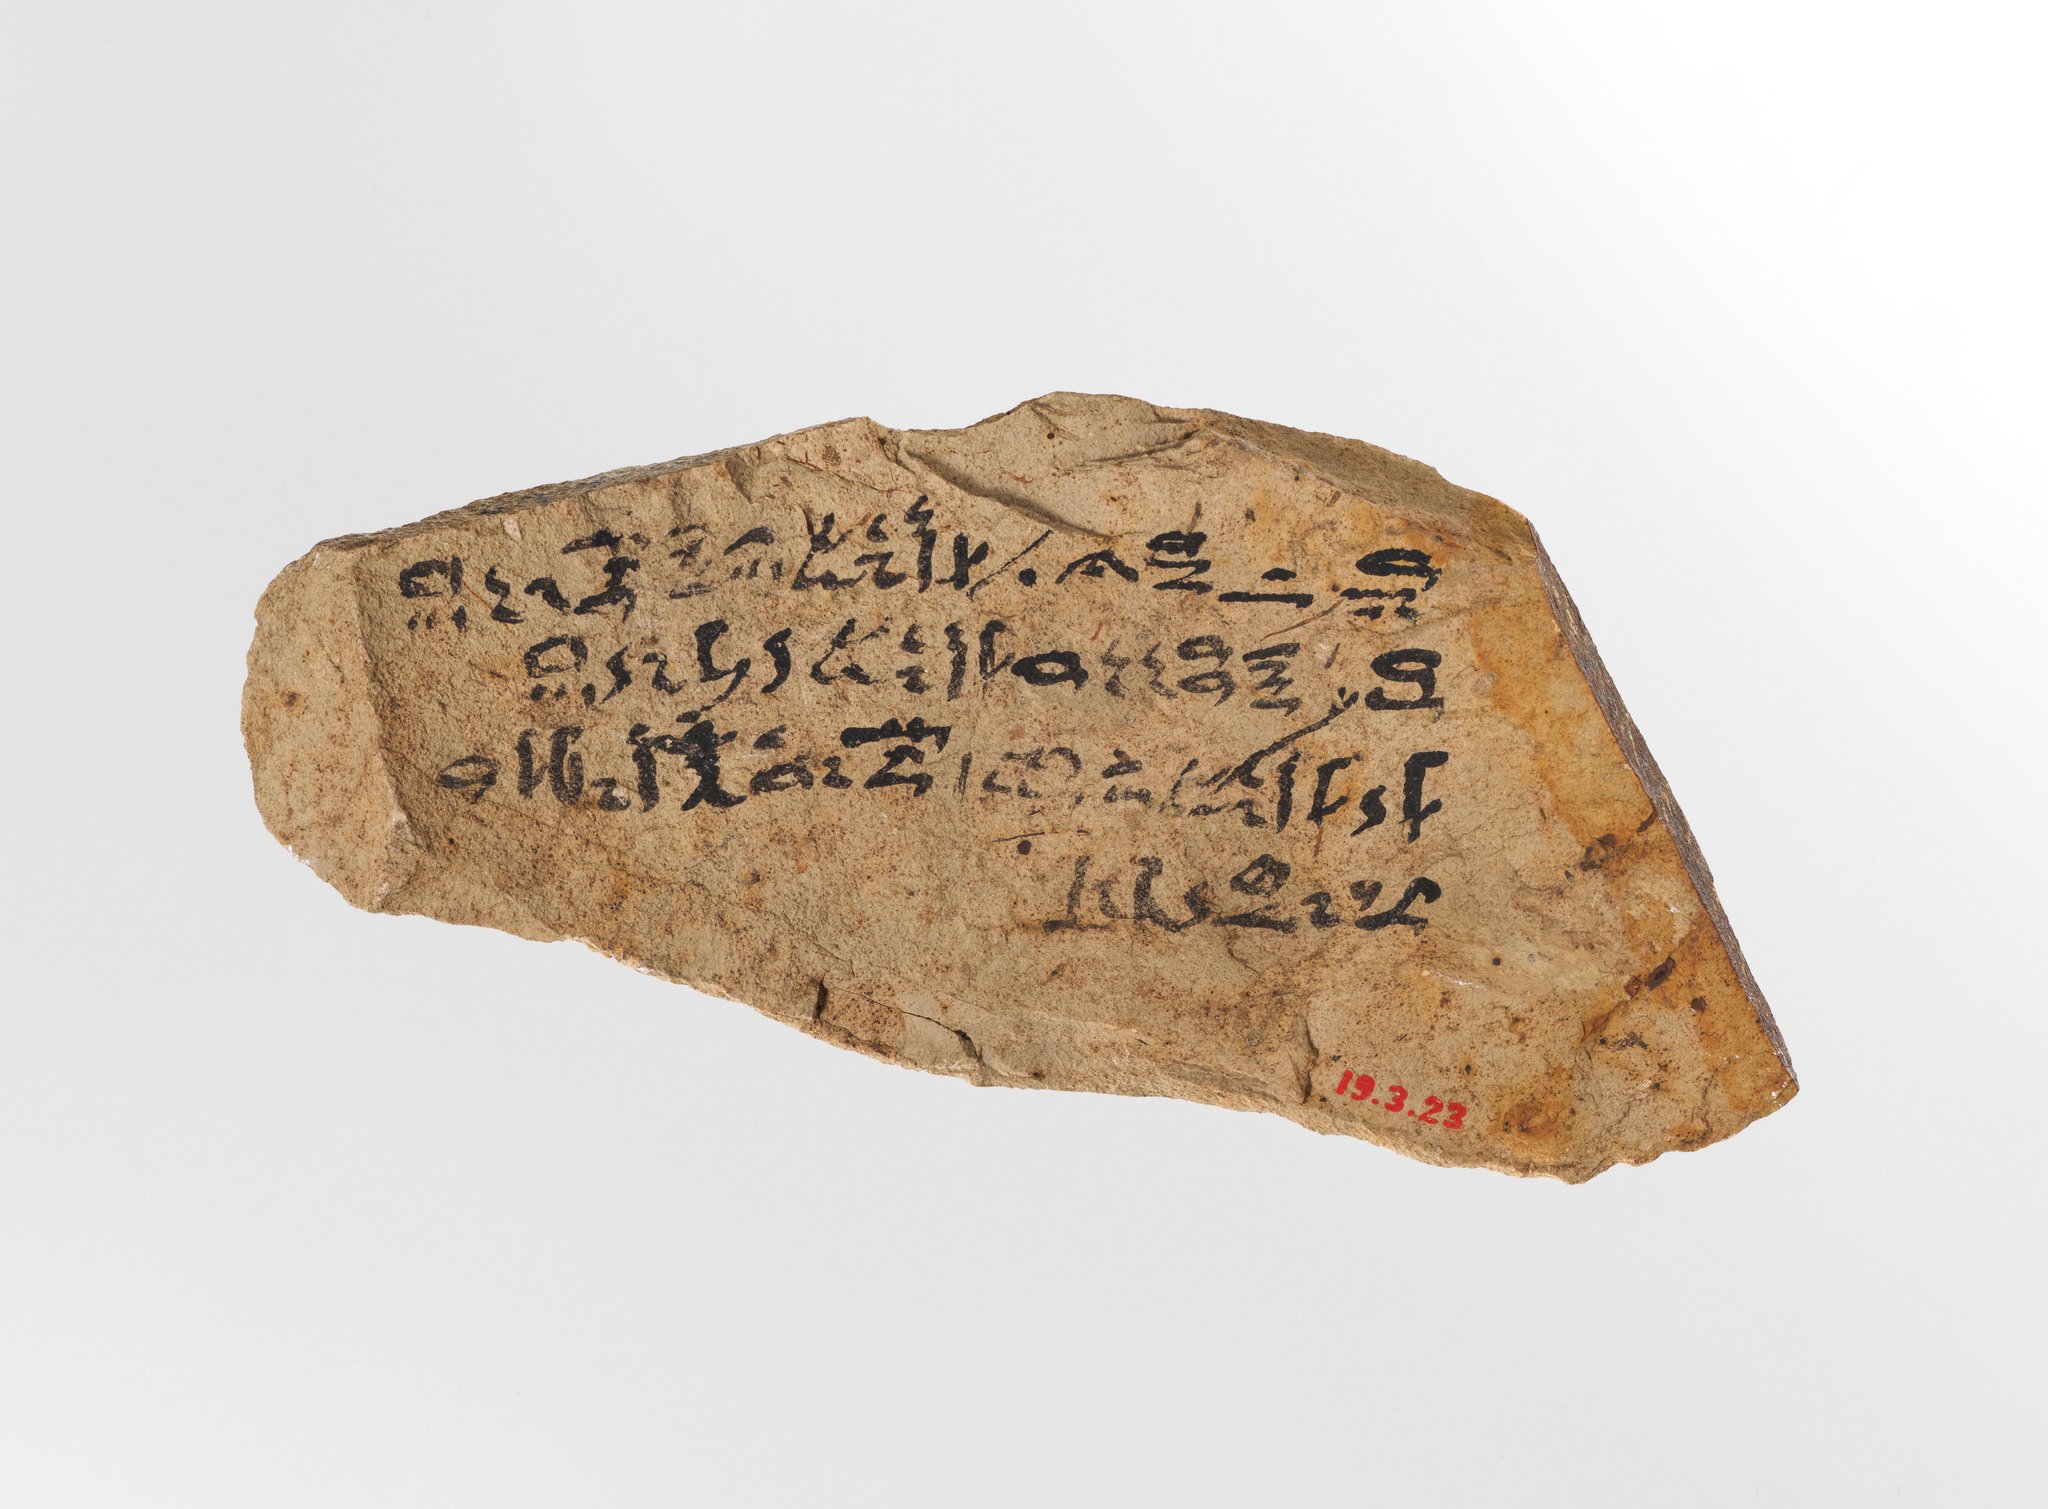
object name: ostracon, hieratic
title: Ostracon with hieratic inscription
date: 1295-525 BCE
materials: ink, limestone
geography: egypt